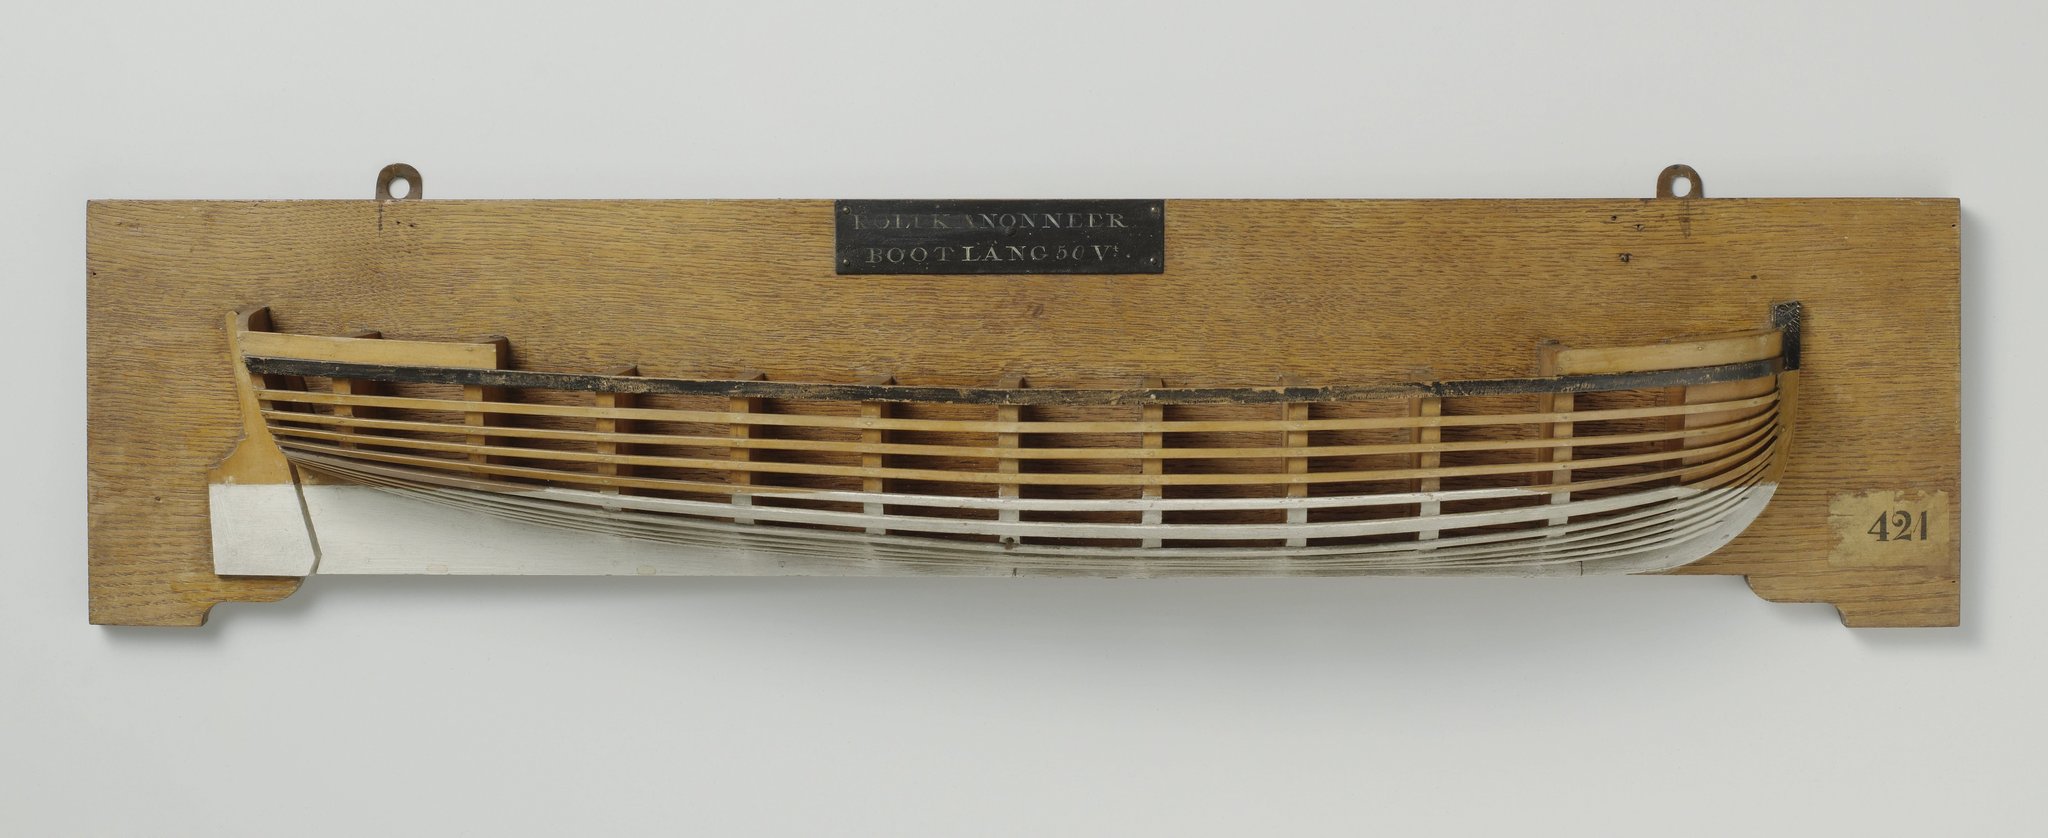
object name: half model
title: Half Model of an Oared Gunboat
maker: Anonymous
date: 1780-1820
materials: wood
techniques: polychromy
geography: netherlands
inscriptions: label, bottom right: ‘421’ former inventory label, inscription, top centre, on a rectangular black label: ‘ROEIKANONNEER / BOOT LANG 50 Vt.’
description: Gepolychromeerd mallenmodel (stuurboord). De huid boven het barkhout is gesloten bij de boeg en in het achterschip. Platte spiegel, breed roer. De zeeg loopt naar voren iets op, één barkhout. Het is een roeisloep met gepiekt rondspant. Schaal ca. 1:22 (afgeleid).